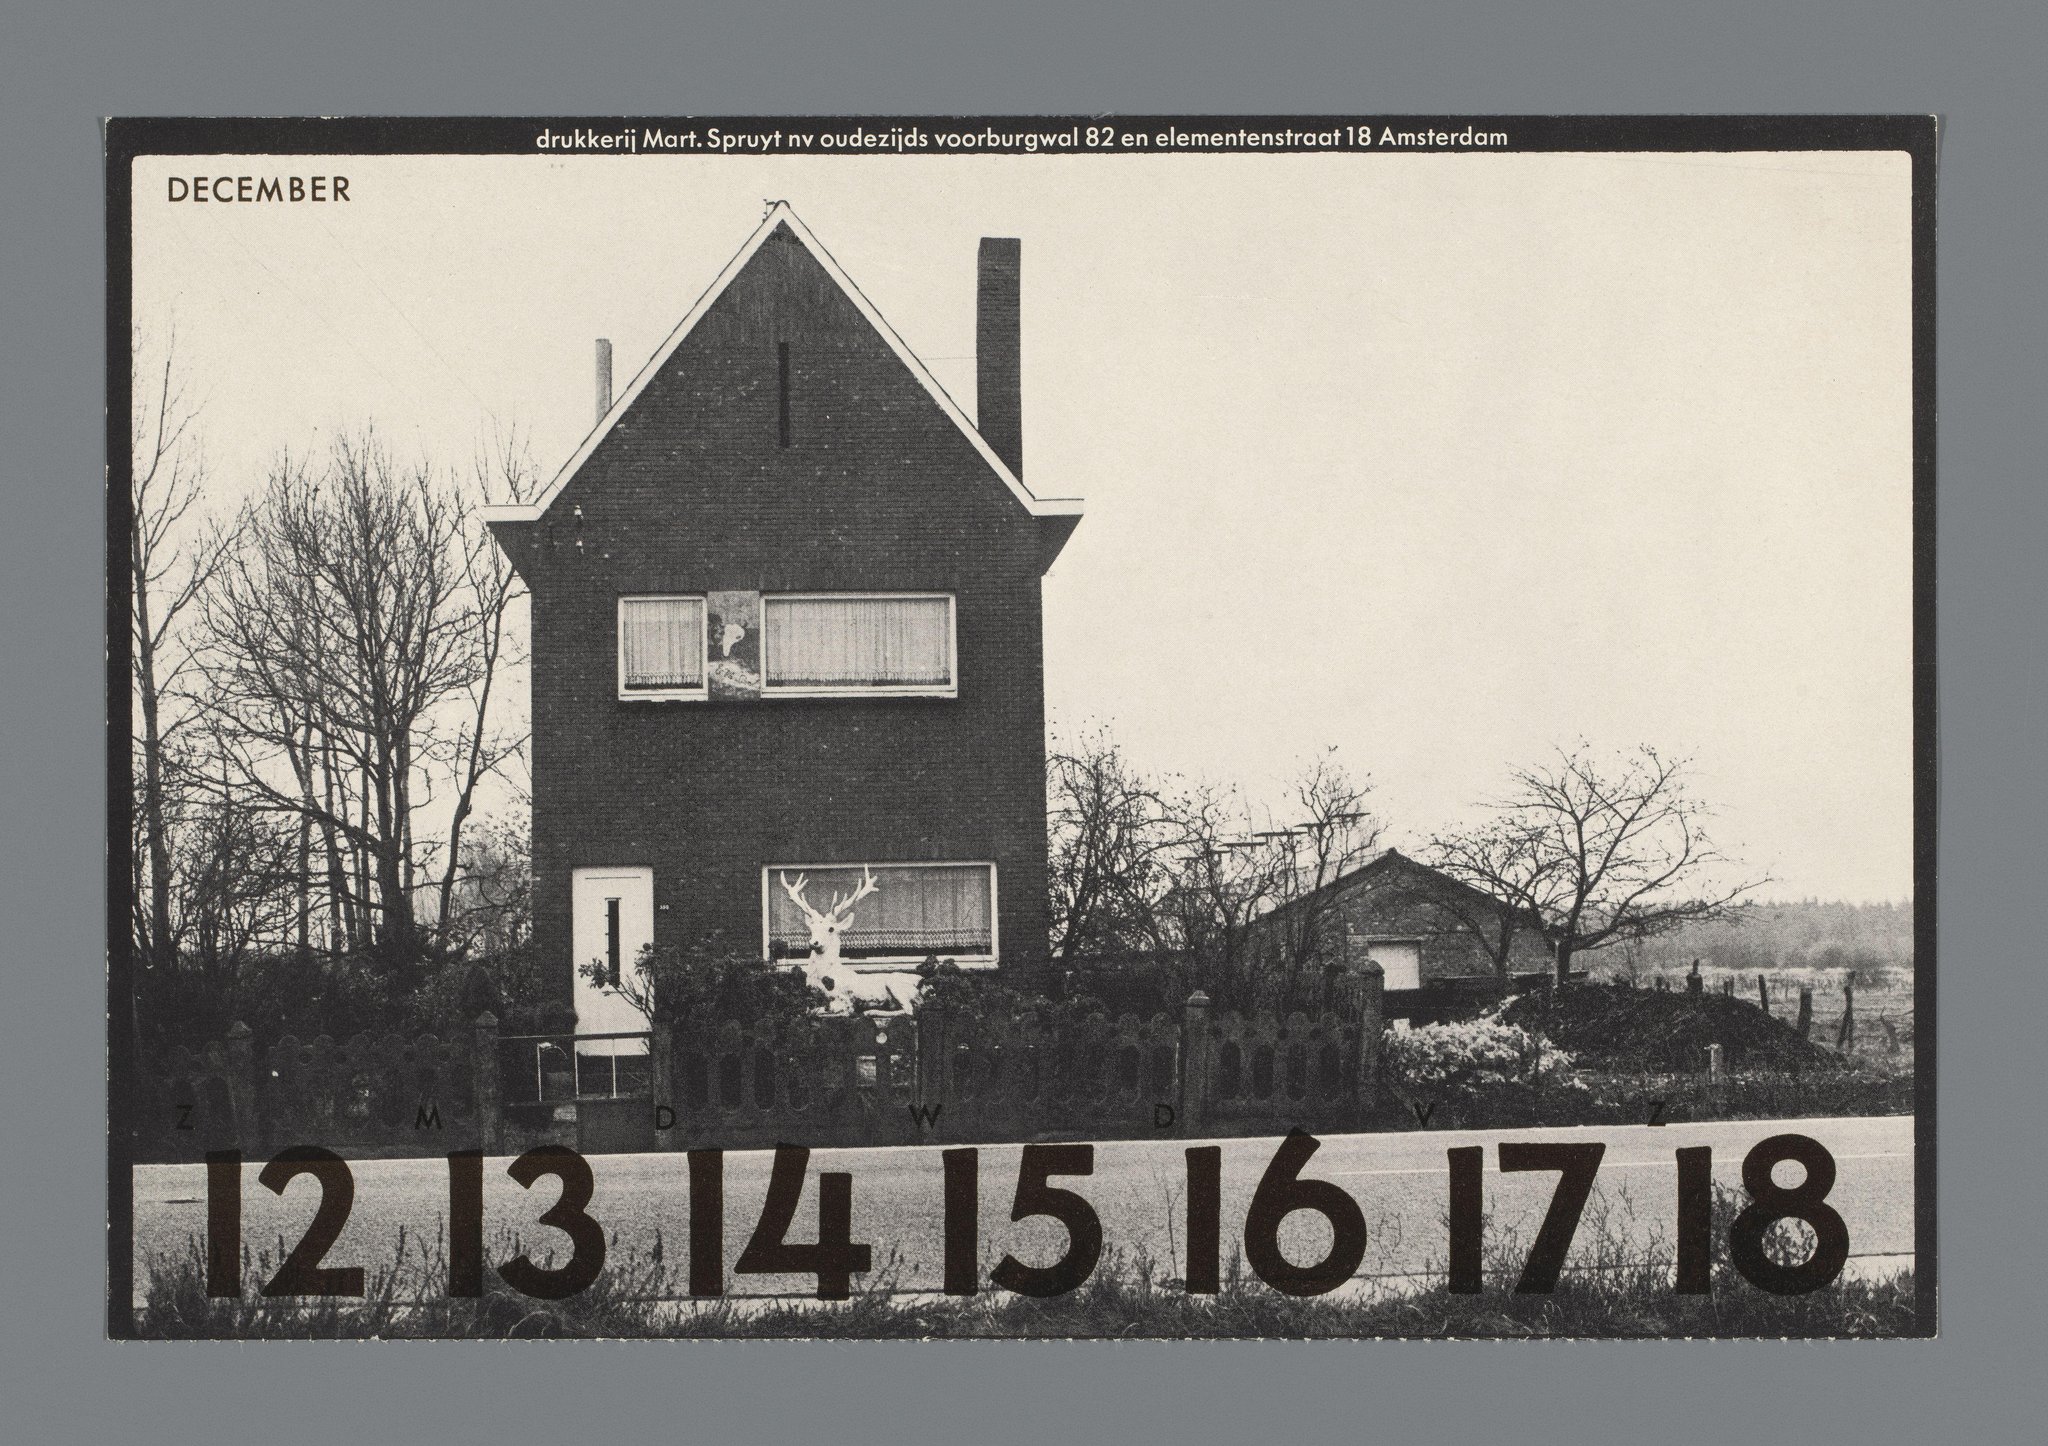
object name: photograph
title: België. Huizen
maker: Anonymous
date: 1900-1950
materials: paper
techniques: offset printed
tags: belgium